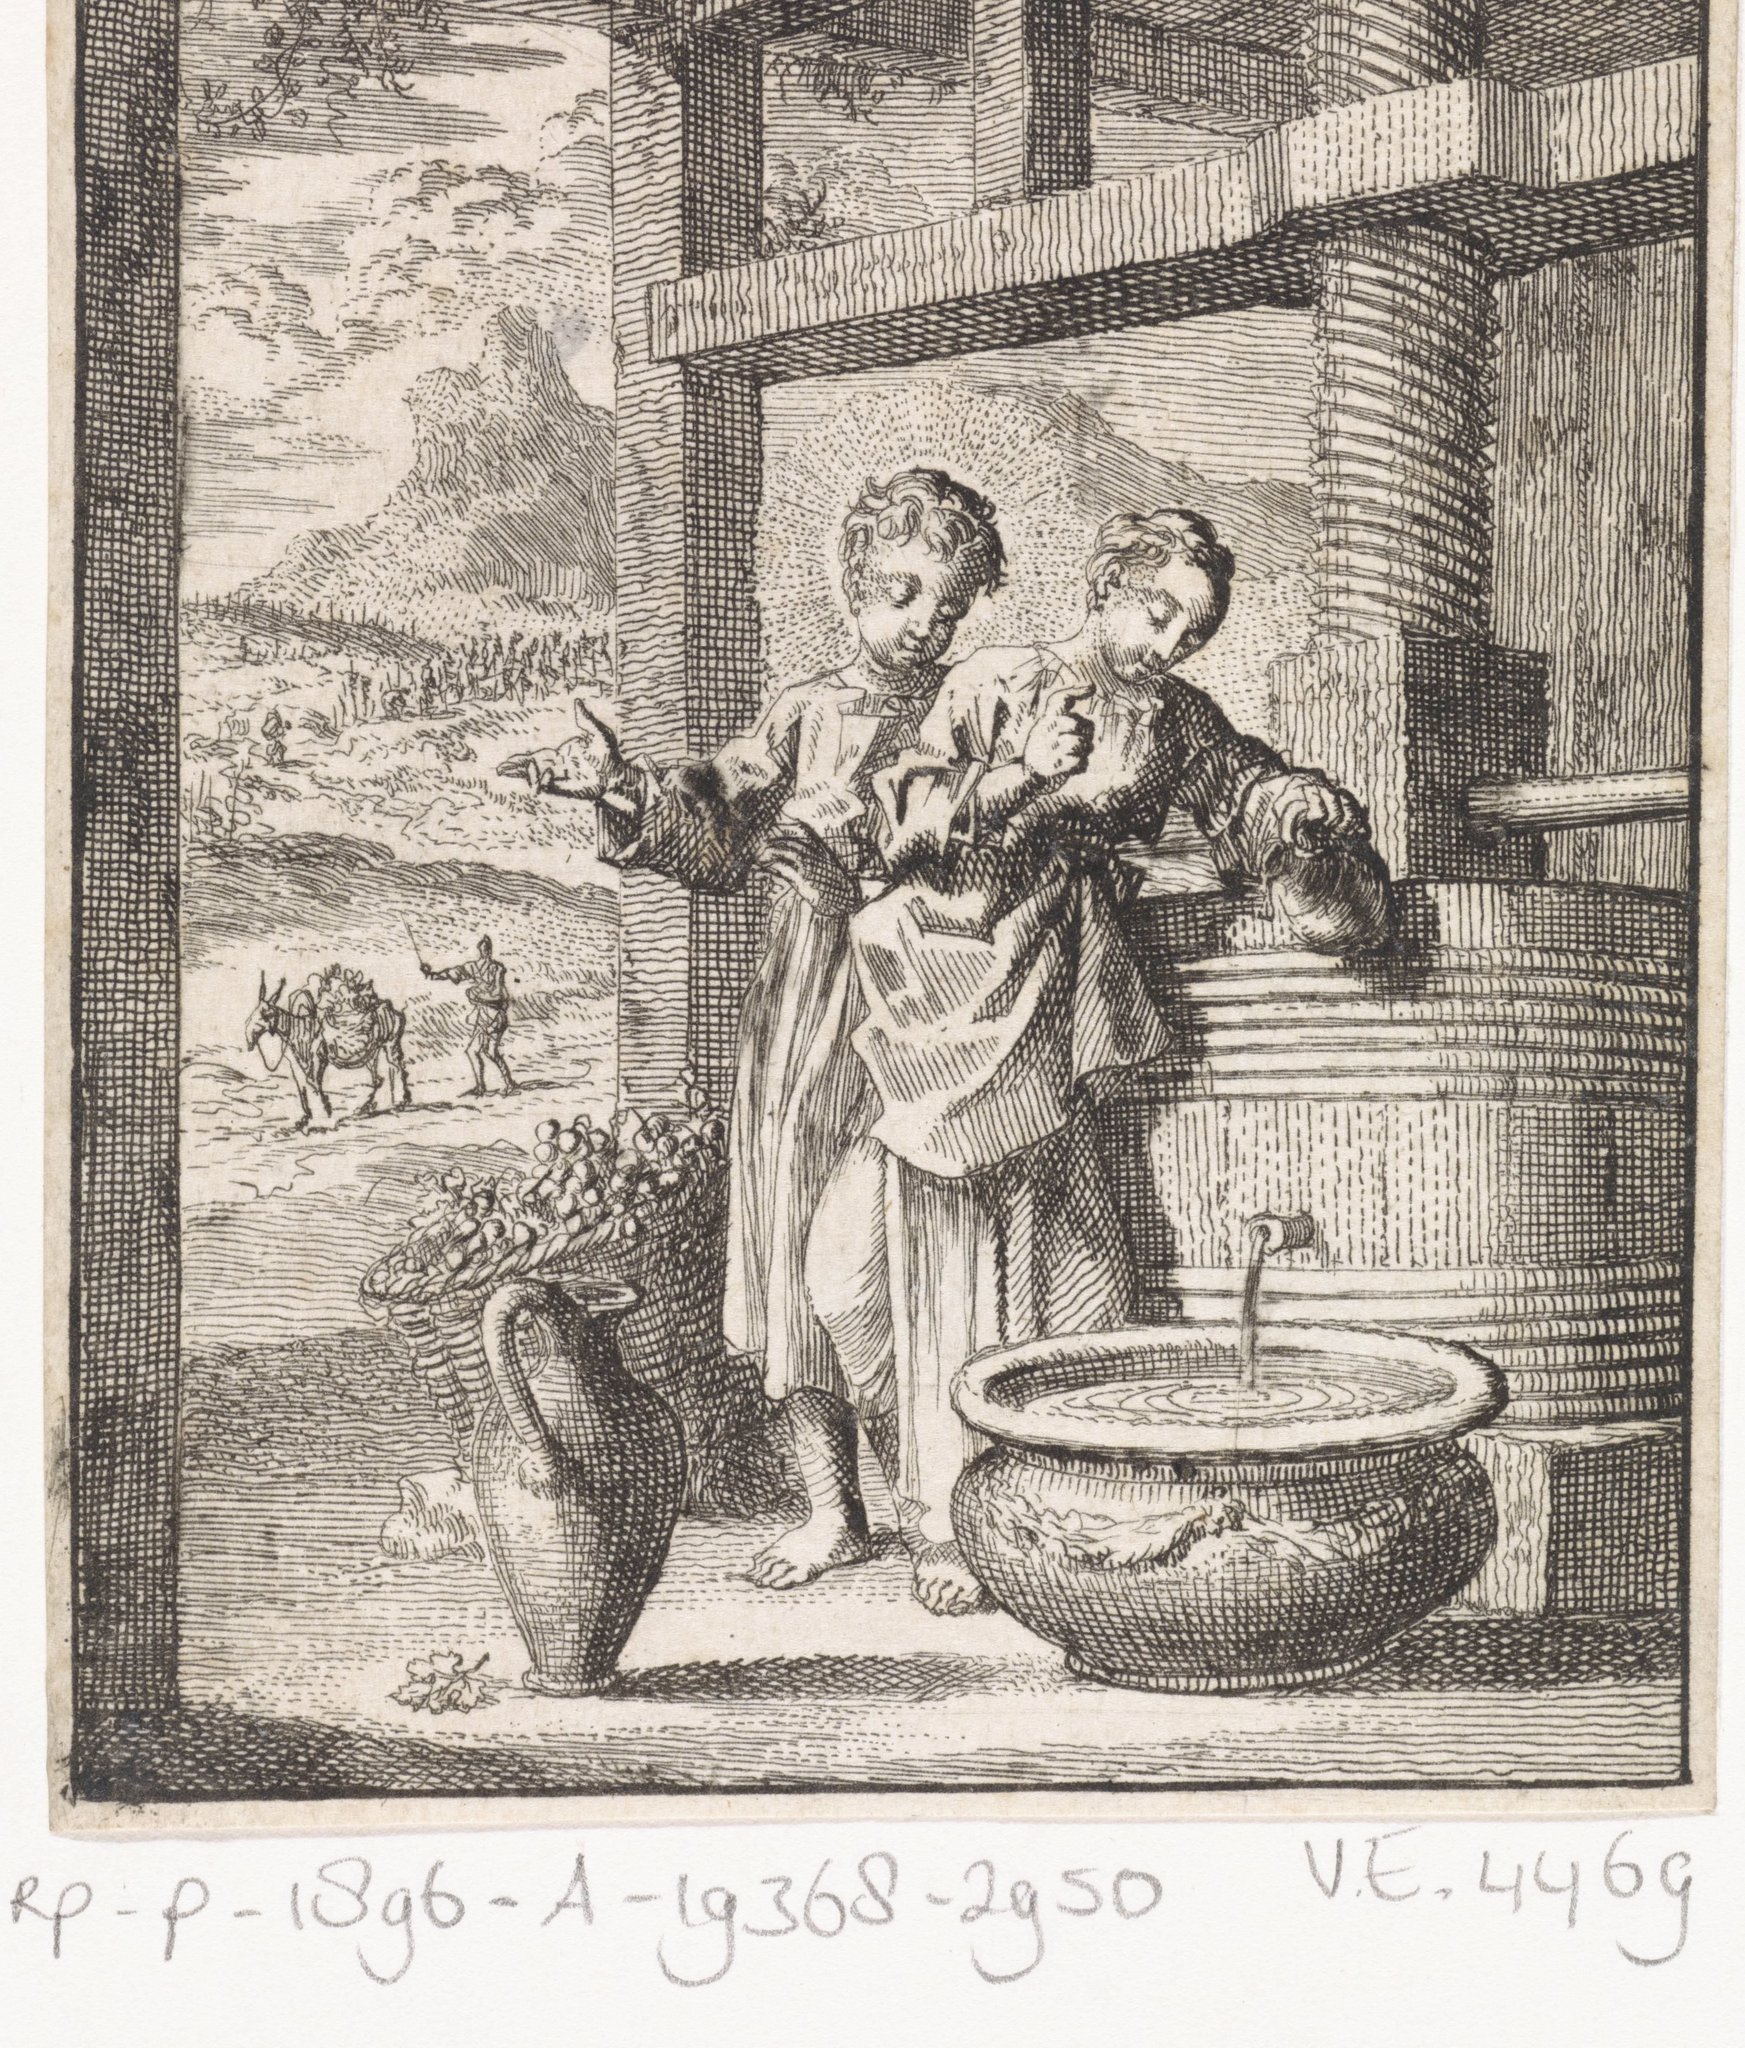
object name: print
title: Jezus en de Ziel bij een wijnpersbak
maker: jan luyken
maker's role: draughtsman, print maker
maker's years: 1649-1712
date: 1714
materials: paper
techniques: etching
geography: amsterdam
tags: wine-press, christ and the soul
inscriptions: collector's mark: Lugt 2228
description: Proefdruk van illustratie uit: Luyken, Jan. Jezus en de Ziel, 3 delen. Amsterdam: Wed. Pieter Arentsz II en Cornelis van der Sys, 1714, dl. III, p. 127.